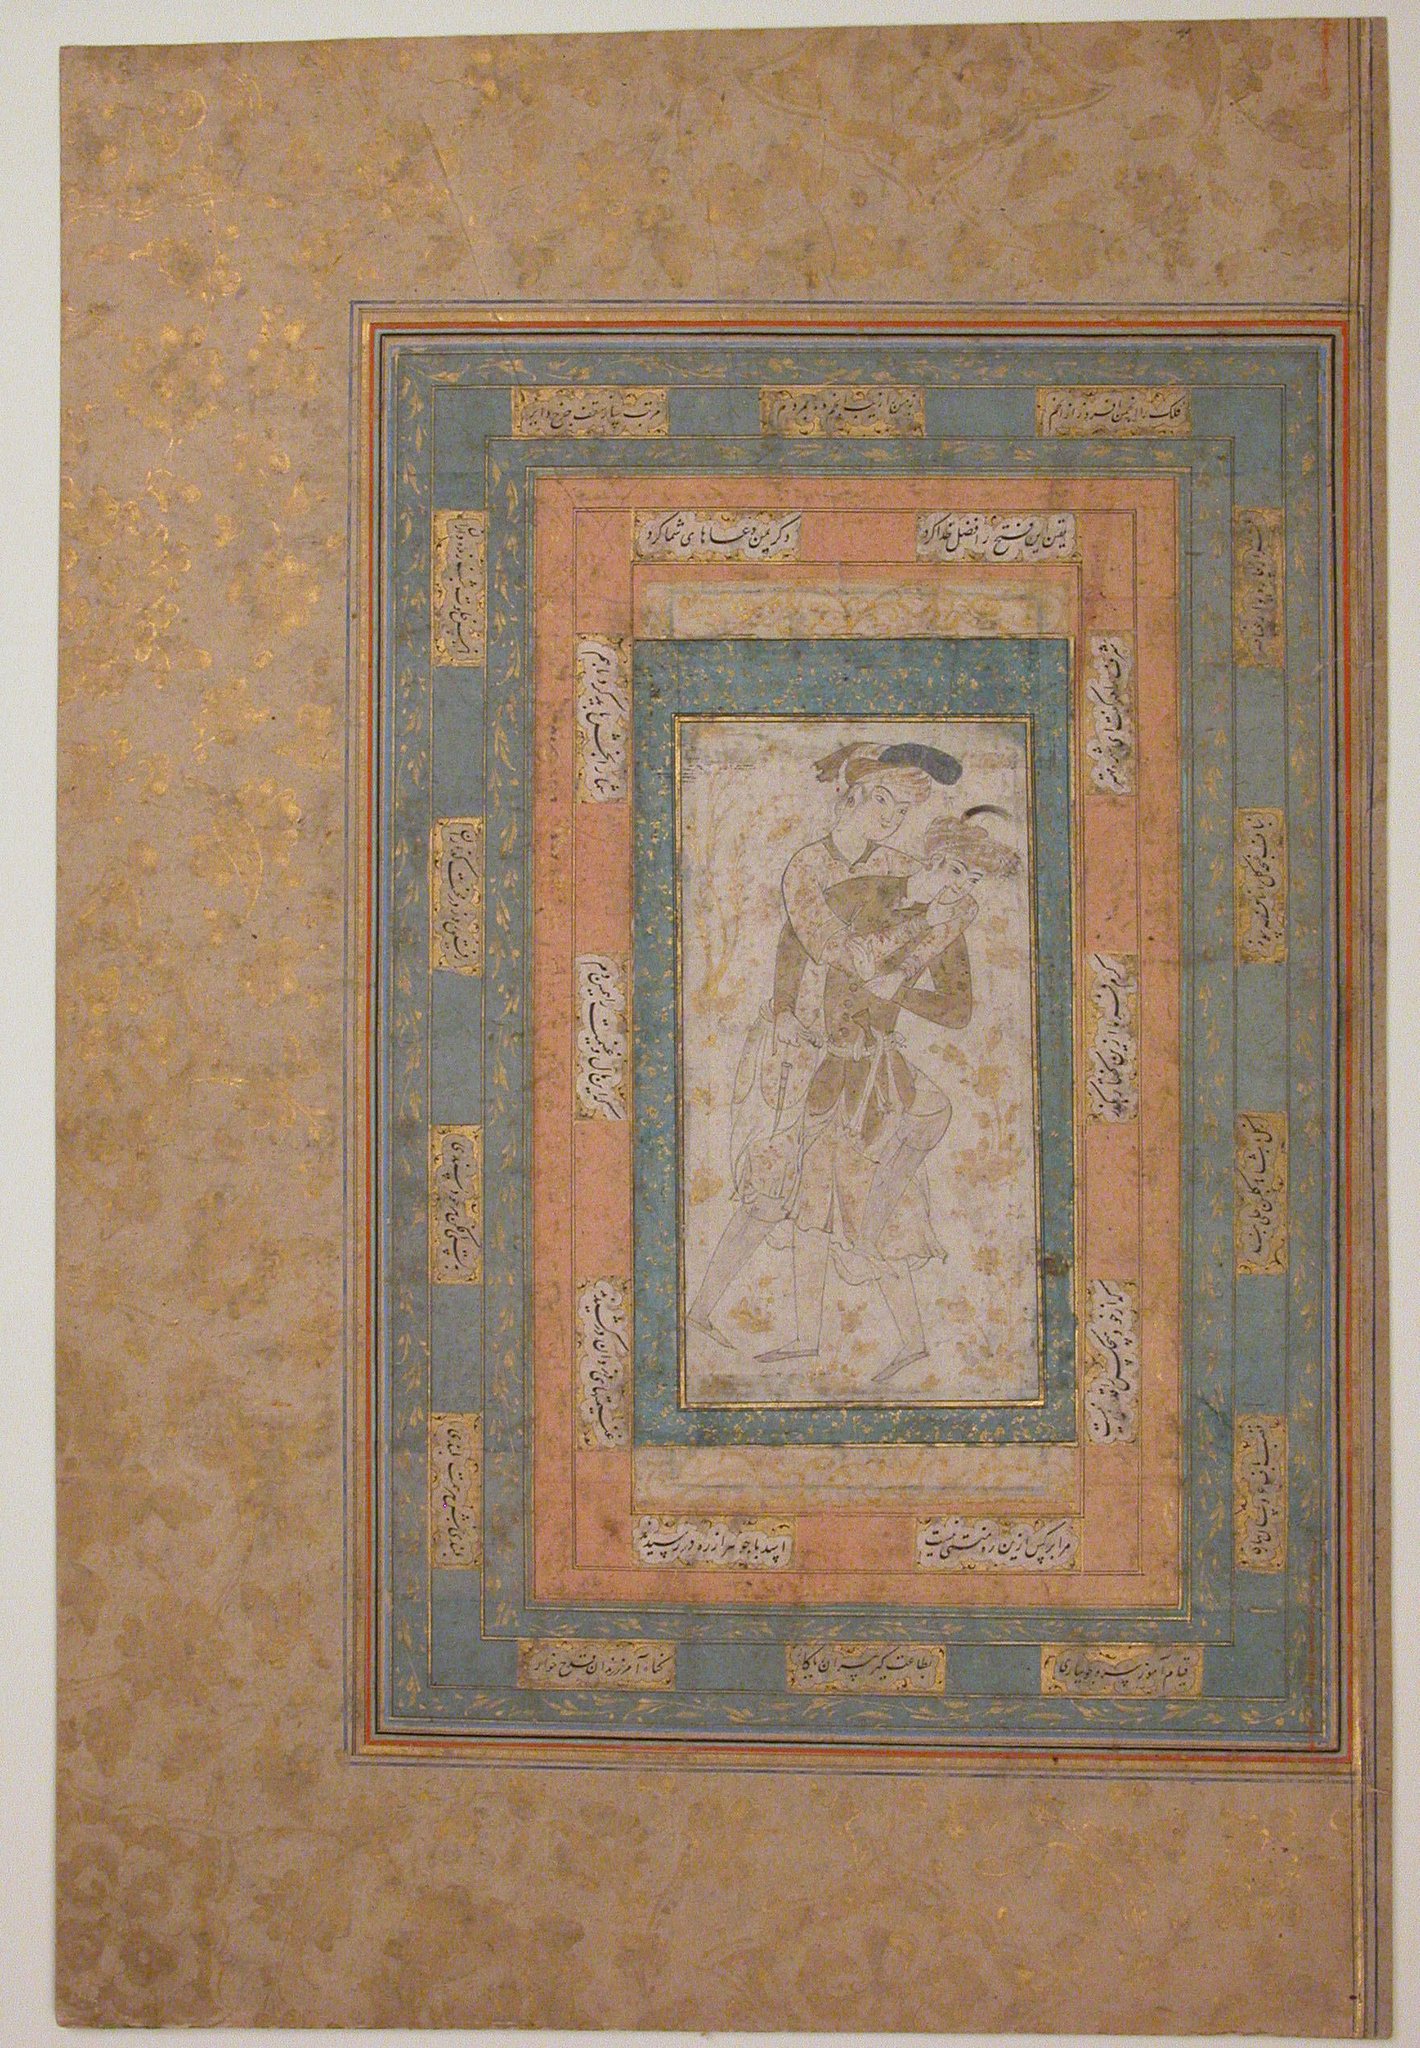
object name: illustrated single work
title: Two Youths Romping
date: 1567-1600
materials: gold, ink, paper, pencil, watercolor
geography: iran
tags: boys,playing